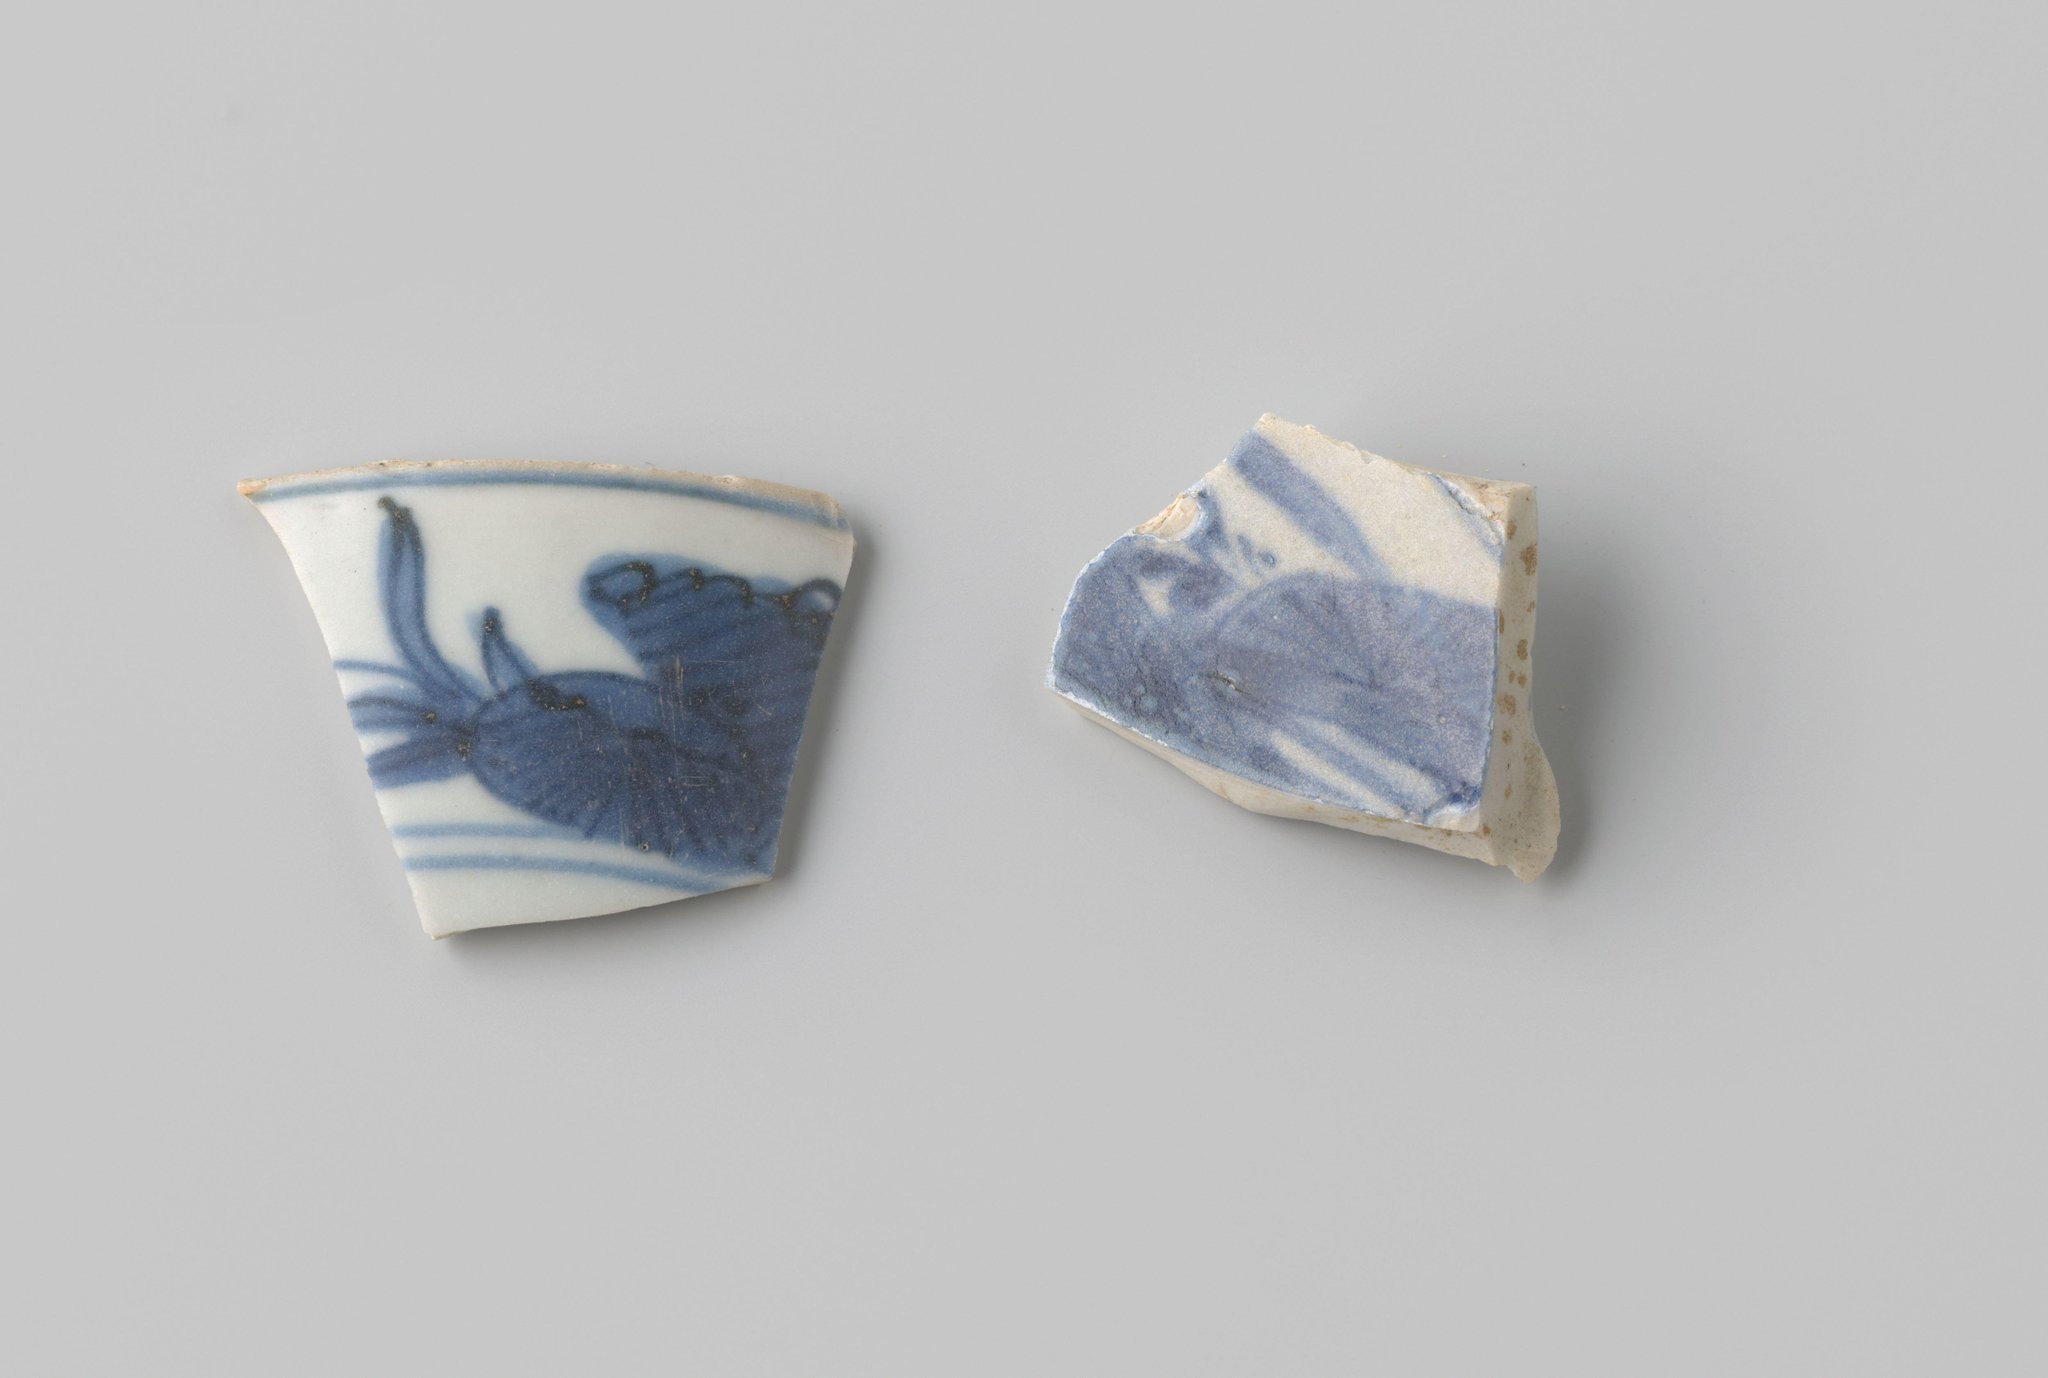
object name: bowl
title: Scherven van kommen uit V.O.C.-schip de 'Witte Leeuw'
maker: Anonymous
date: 1613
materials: porcelain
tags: verenigde oostindische compagnie, sint-helena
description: Scherven van kommen uit V.O.C.-schip de 'Witte Leeuw'.